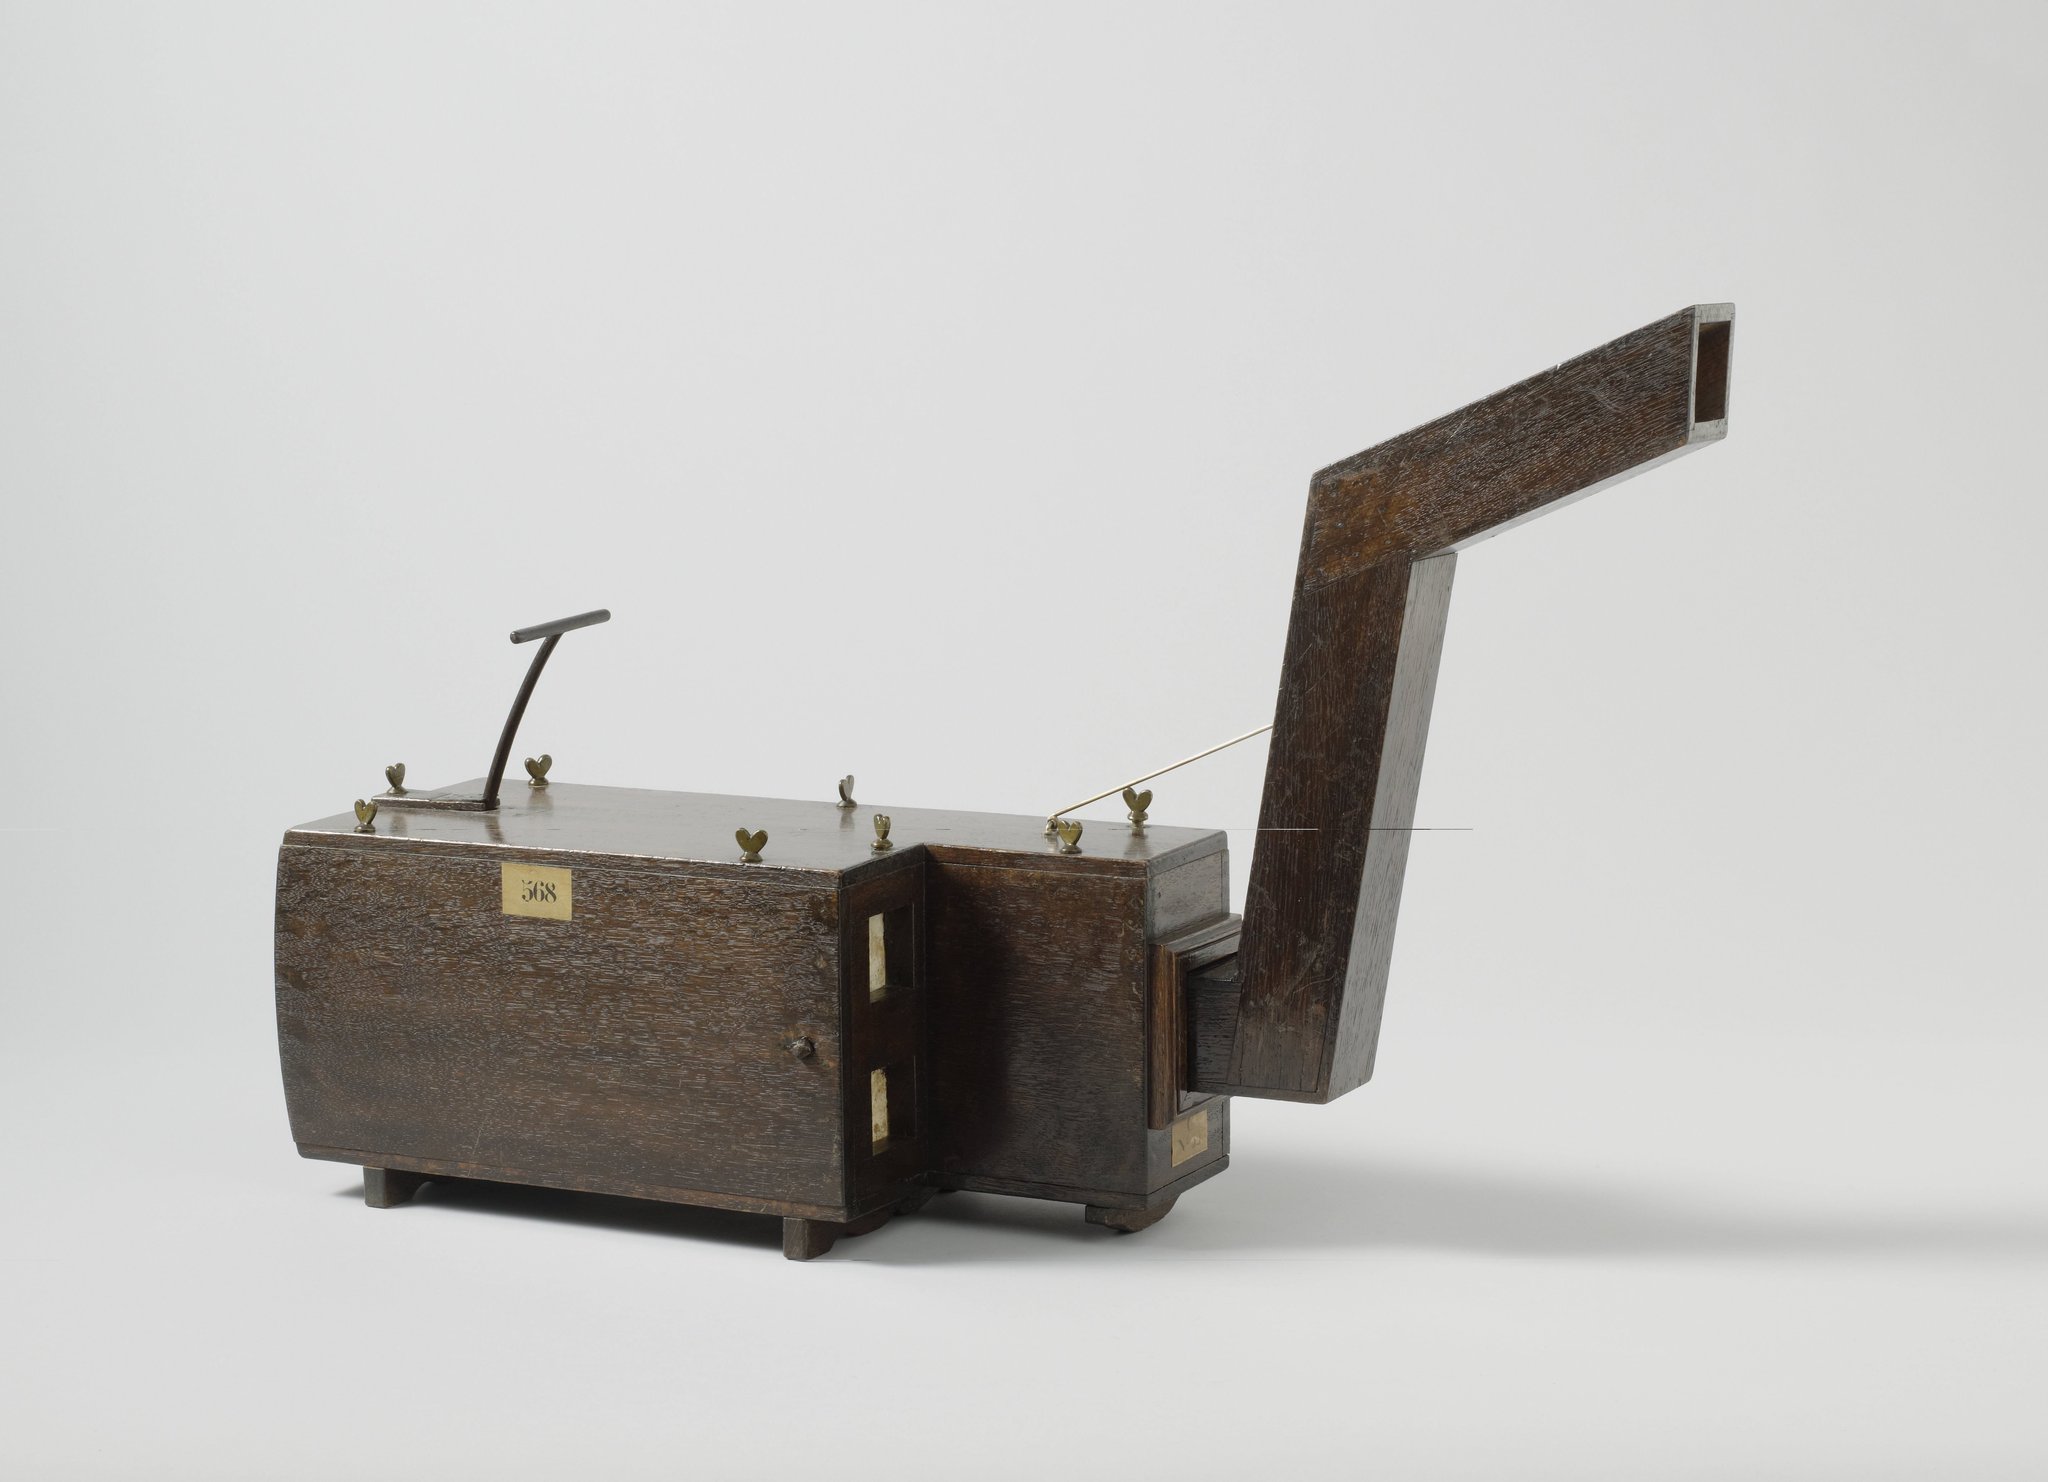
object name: demonstration model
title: Model of a Ventilator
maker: Anonymous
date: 1800-1850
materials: brass, leather, iron, wood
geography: united kingdom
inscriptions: label, top: ‘568’ former inventory label, inscription, below the ventilation shaft: ‘C / Nº 34’